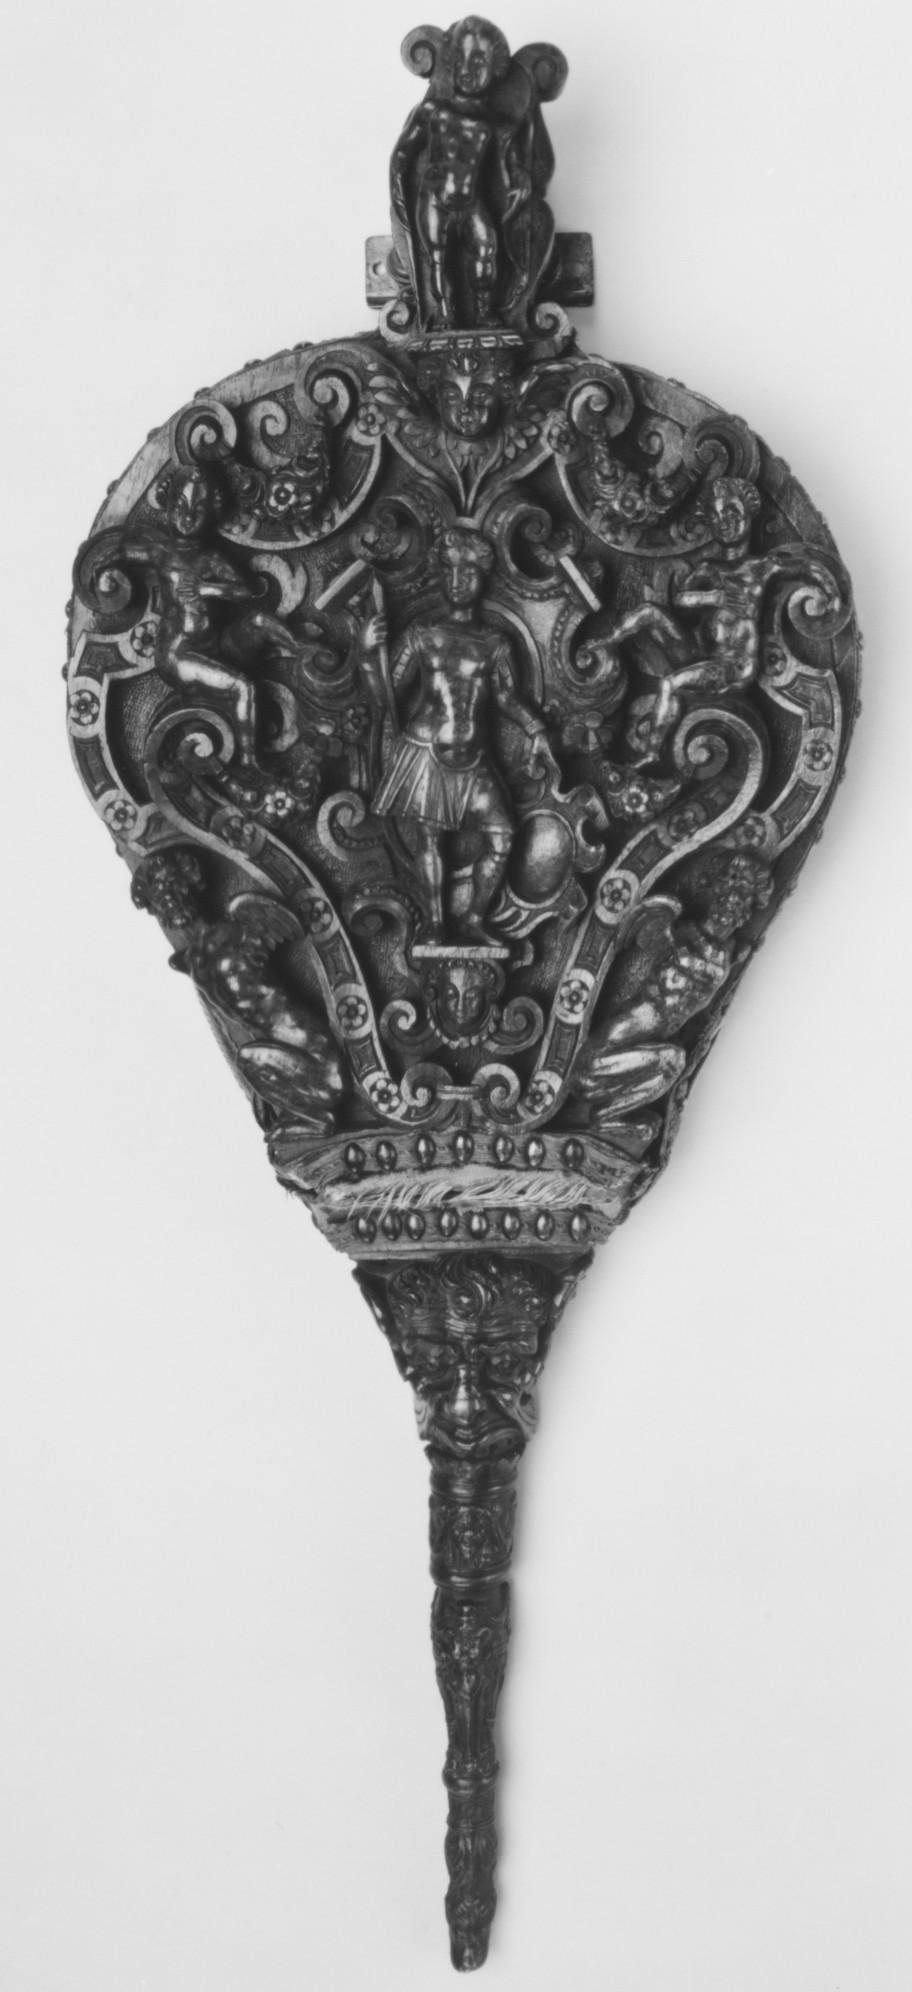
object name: bellow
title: Bellows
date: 1567-1600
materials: bronze, wood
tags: putti,mars